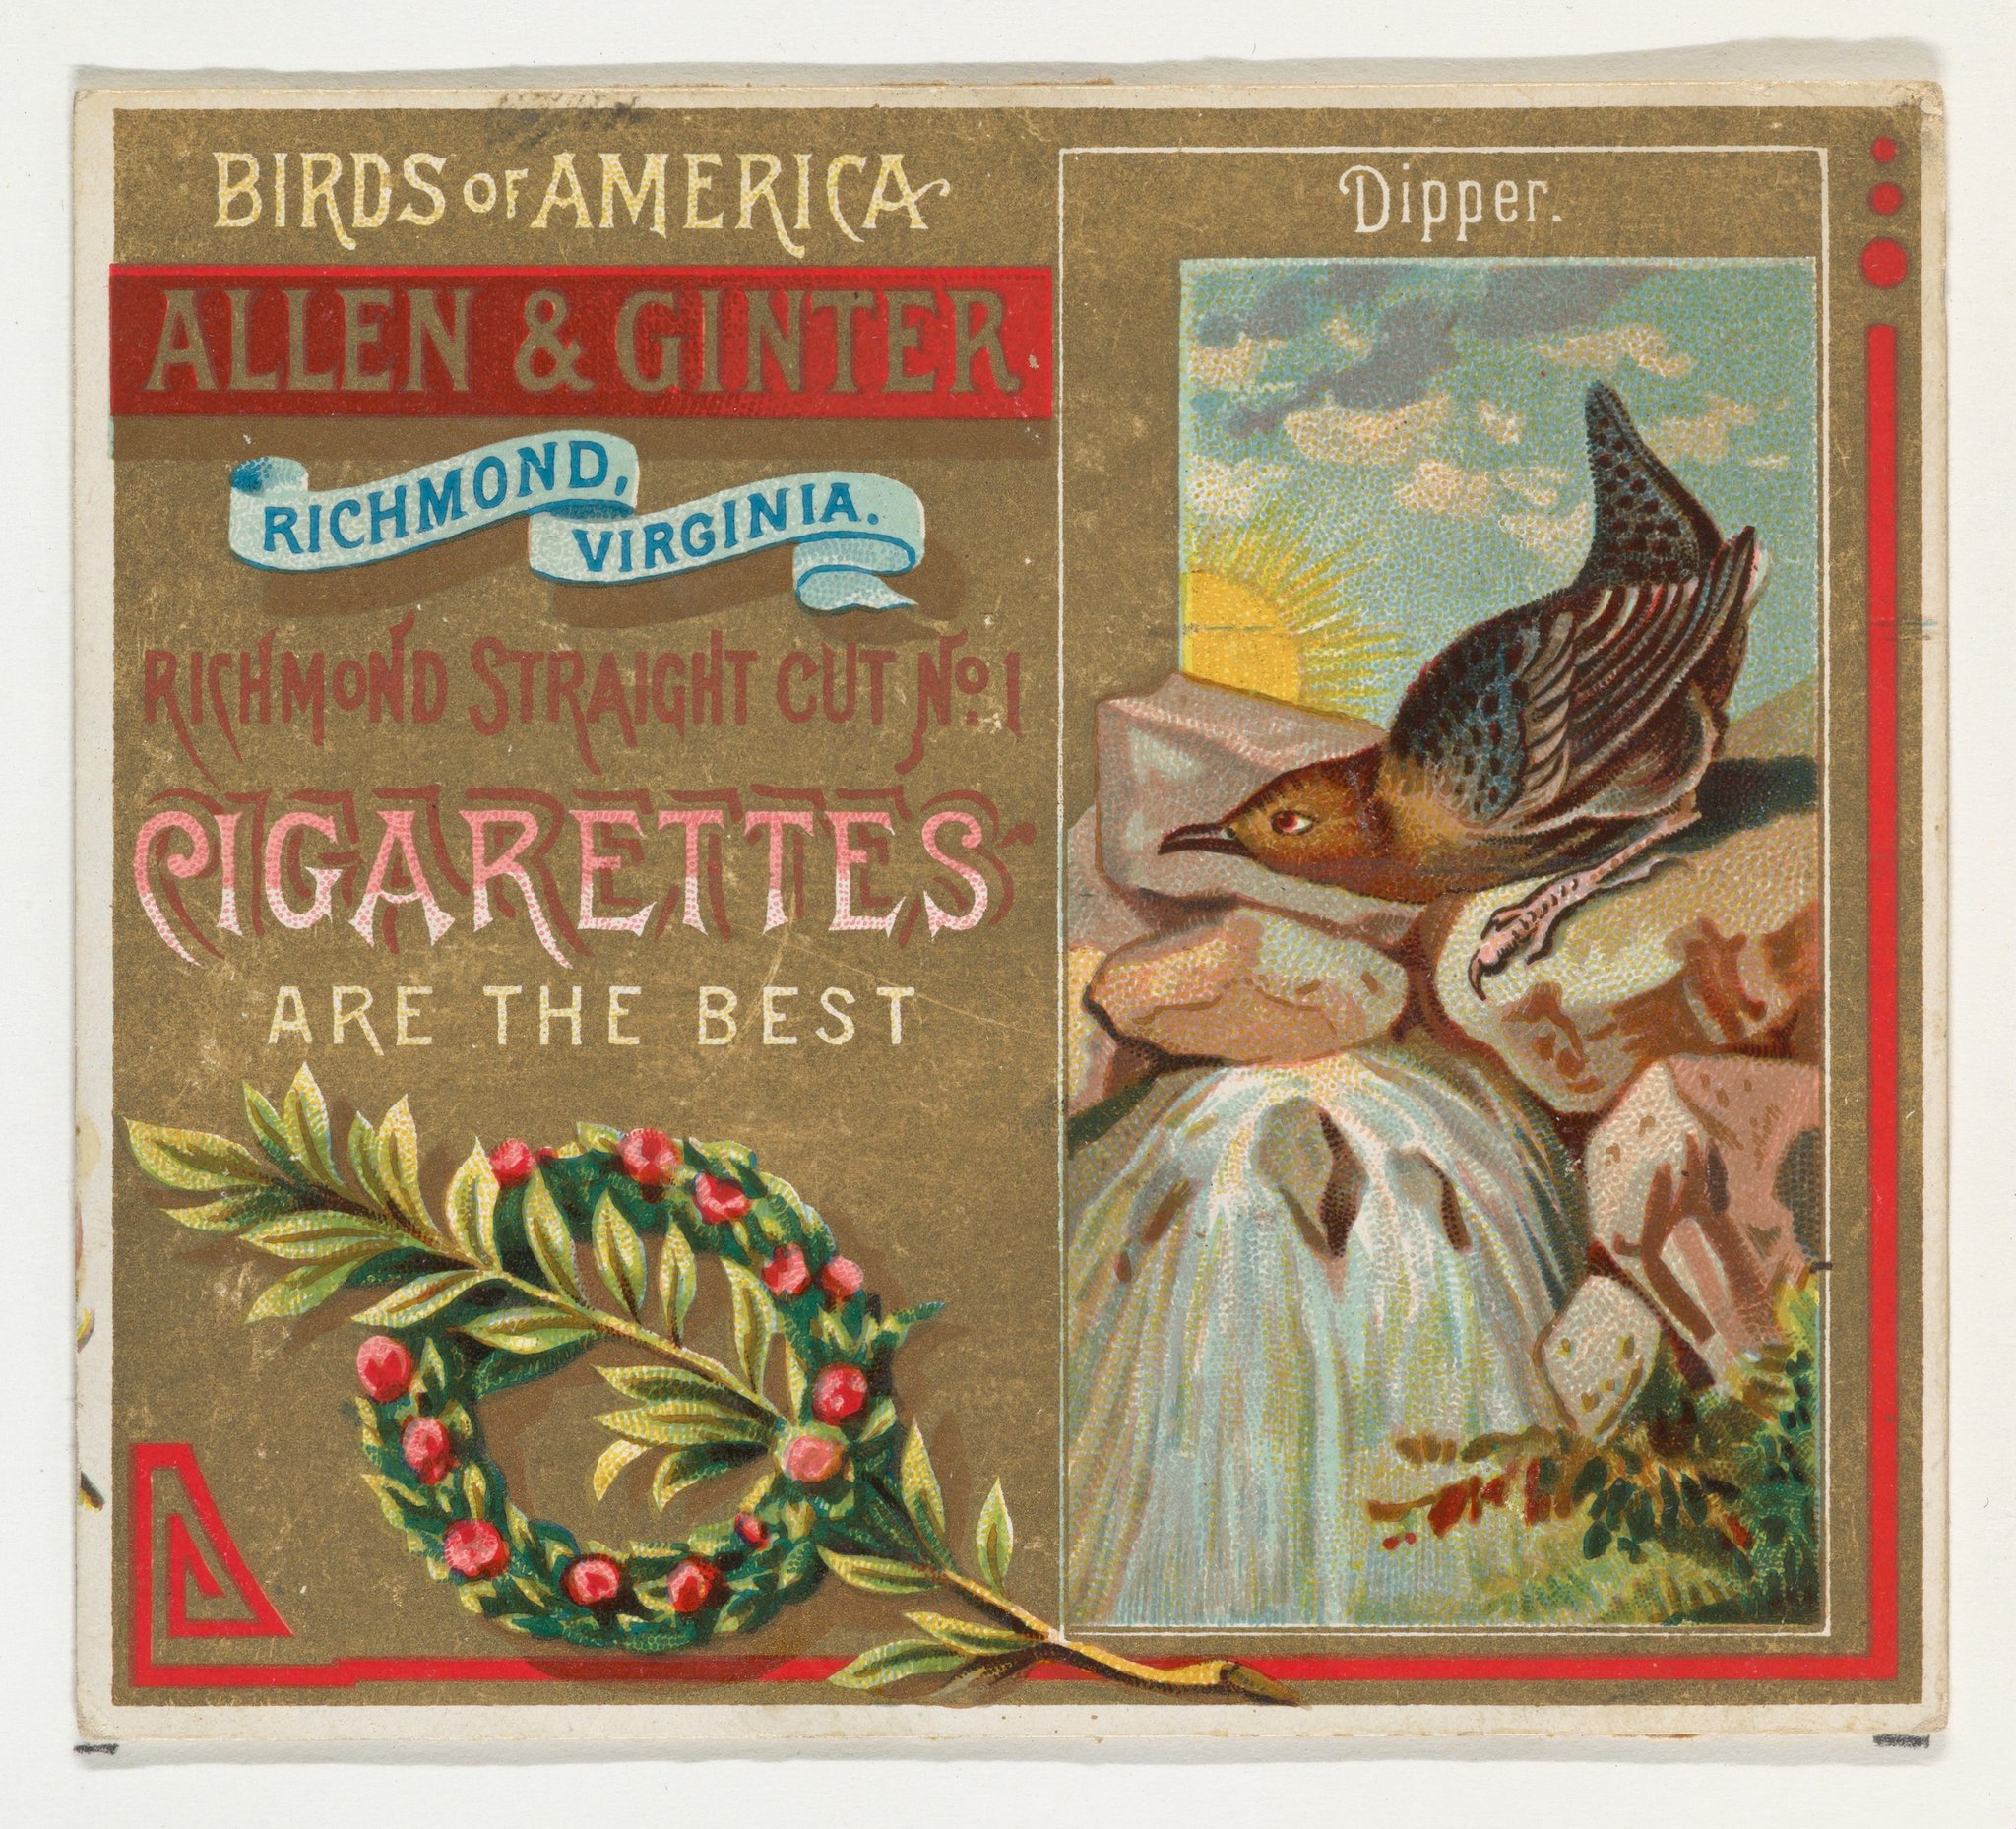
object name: print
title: Dipper, from the Birds of America series (N37) for Allen & Ginter Cigarettes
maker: allen & ginter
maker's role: publisher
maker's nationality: american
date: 1888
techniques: color lithograph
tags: birds